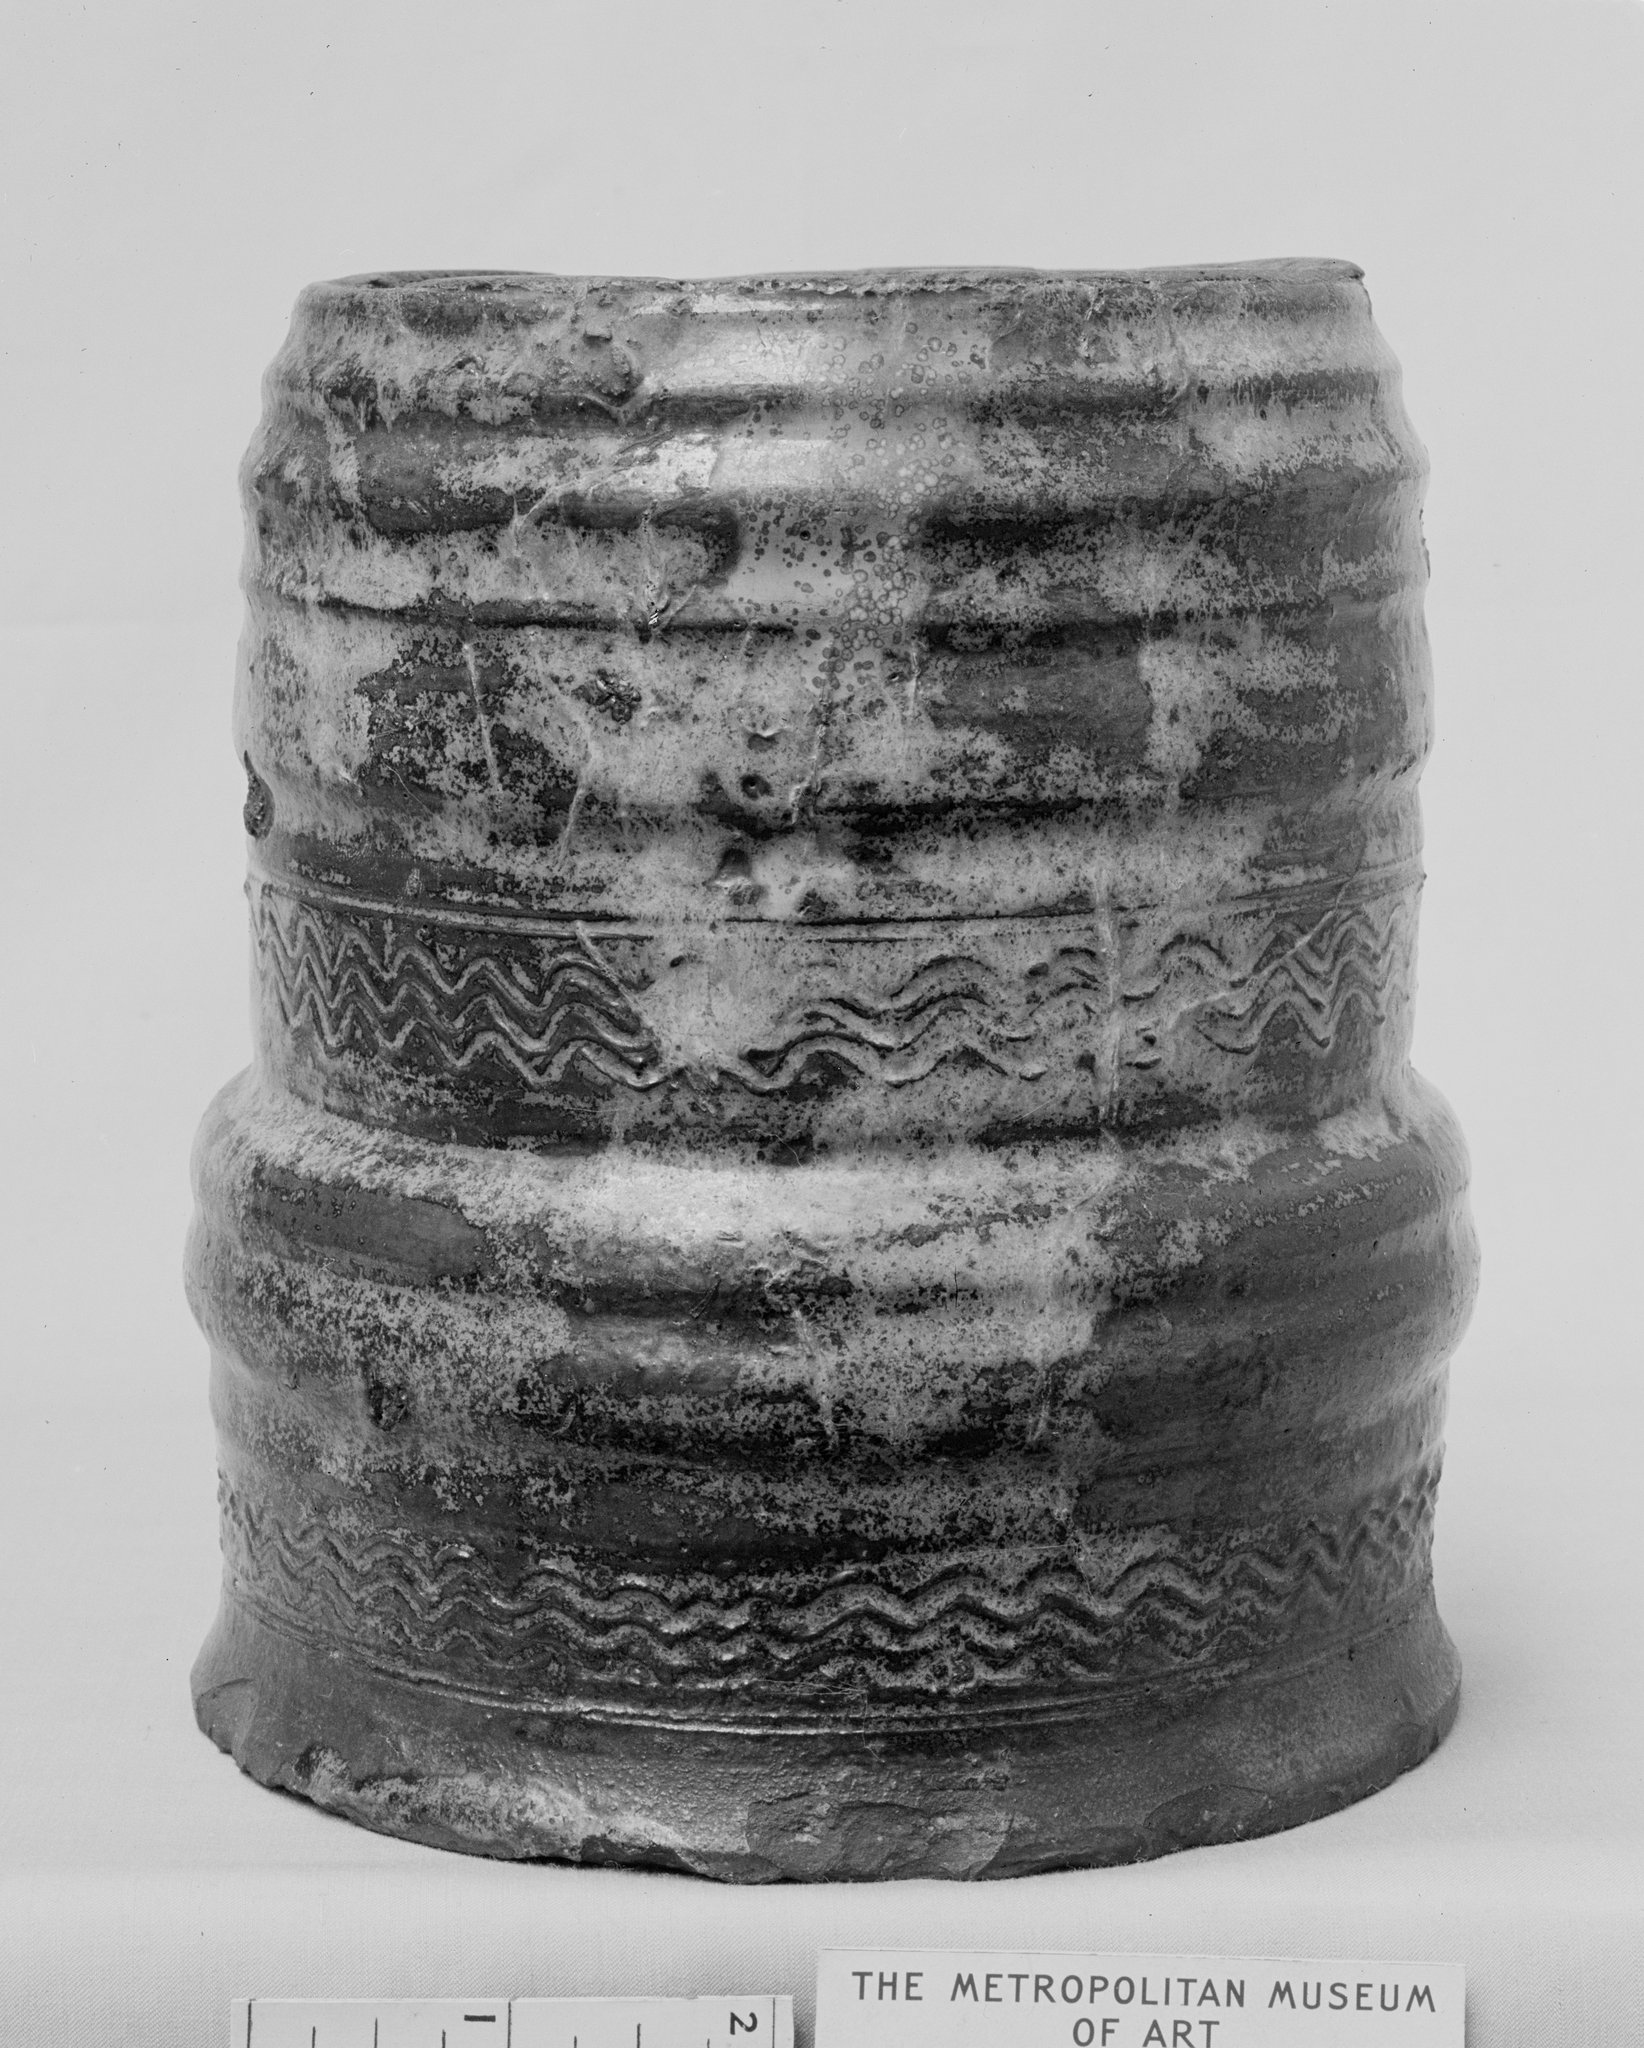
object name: water pot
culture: japanese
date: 1701-1800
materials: clay, glaze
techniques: incising